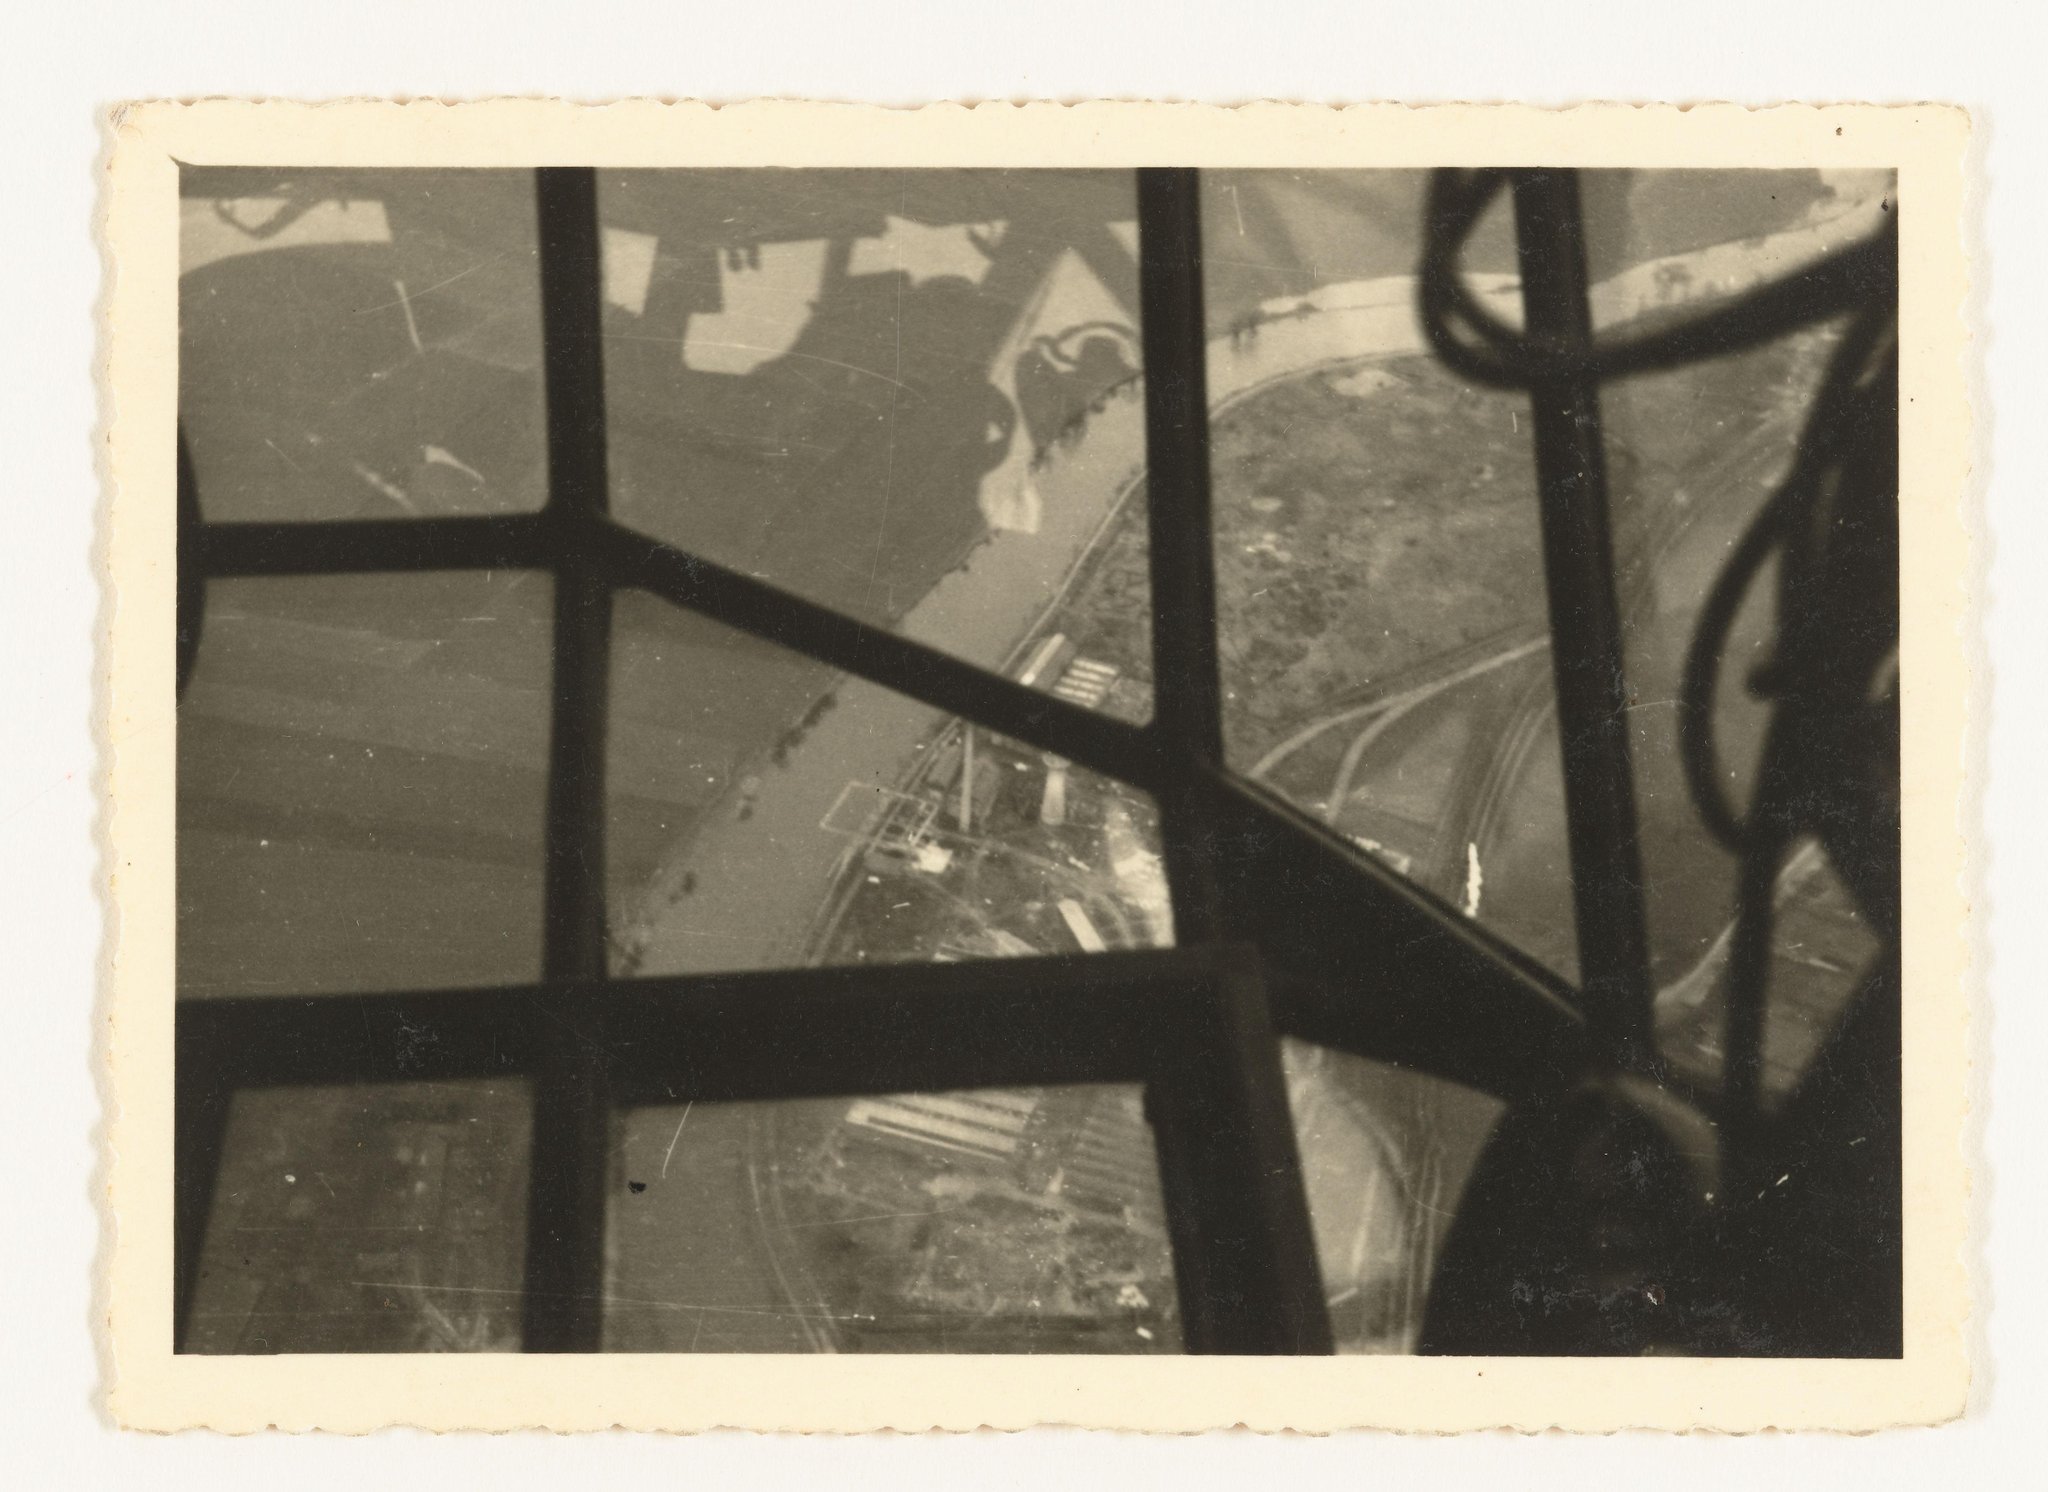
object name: photograph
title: Nederland gezien vanuit Duitse cockpit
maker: Anonymous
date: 1905-1940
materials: photographic support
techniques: gelatin silver print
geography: netherlands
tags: river, battle, fighting in general, netherlands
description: Een deel van Nederland gezien door de ramen van de cockpit van een Duits gevechtsvliegtuig, een Junkers 88, vermoedelijk genomen tijdens de inval in Nederland op of direct na 10 mei 1940. Beneden is een rivier te zien en iets wat lijkt op een treinstation.